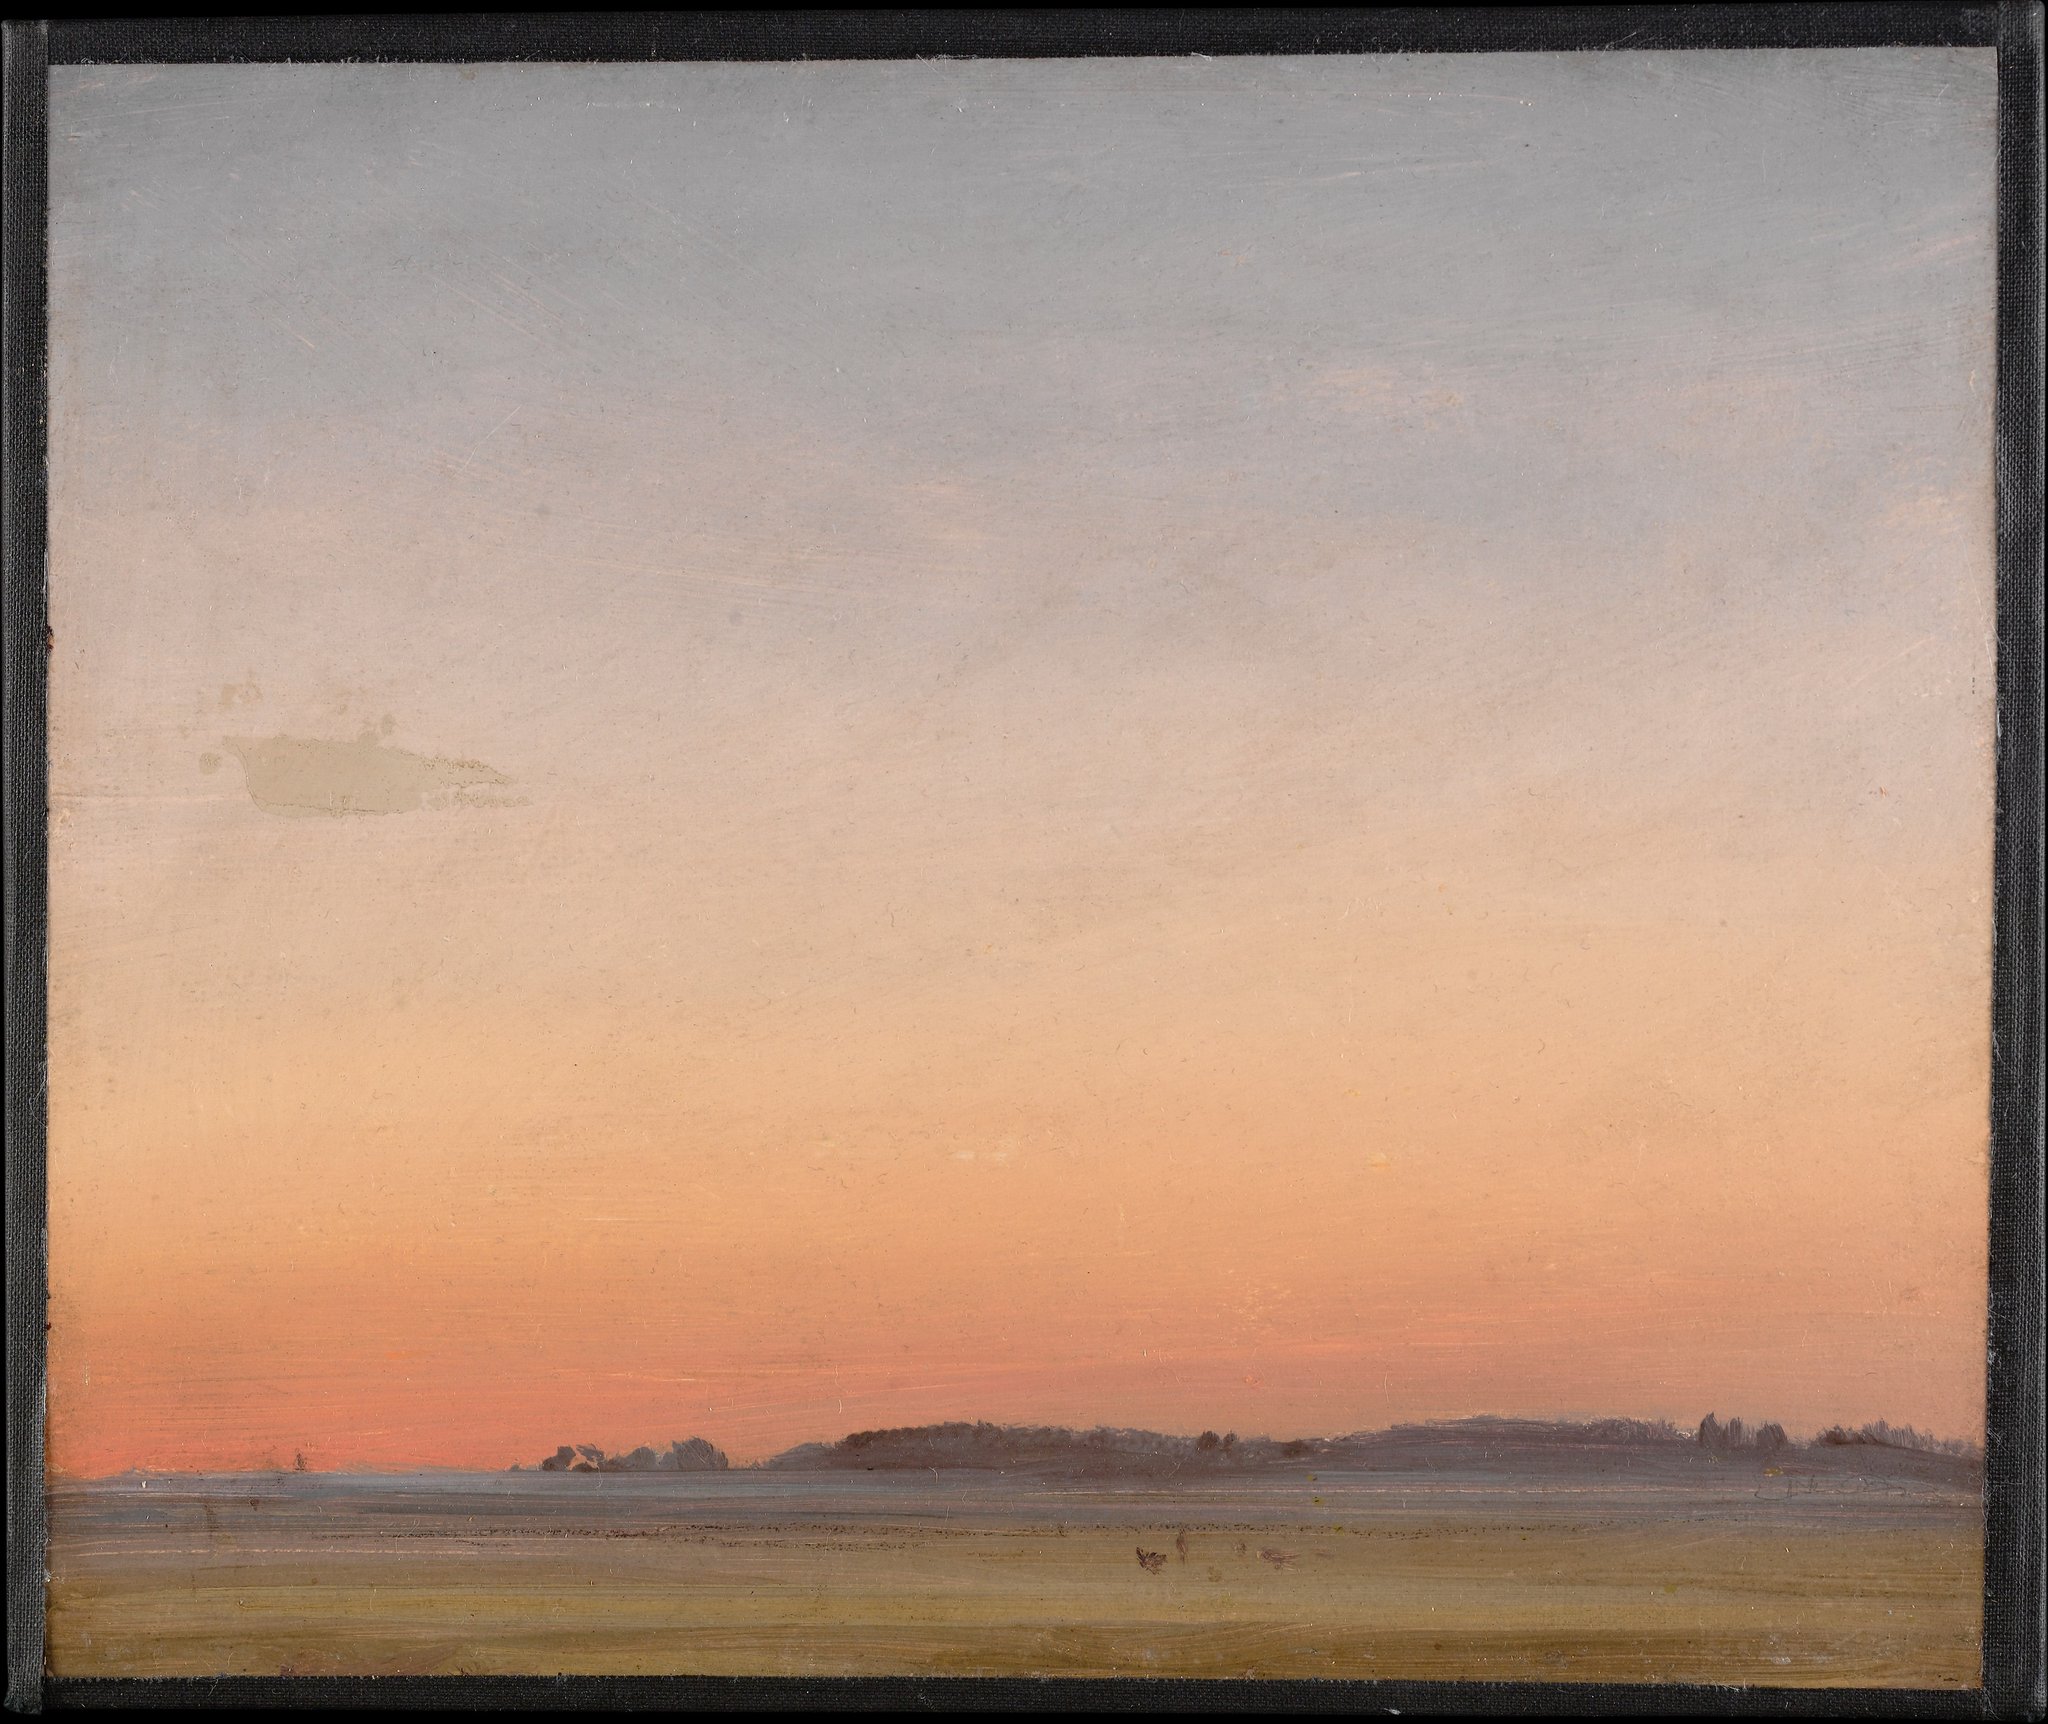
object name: painting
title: Landscape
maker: carl rottmann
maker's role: artist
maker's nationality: german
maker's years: 1797-1850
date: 1835-1845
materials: board, oil, paper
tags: landscapes